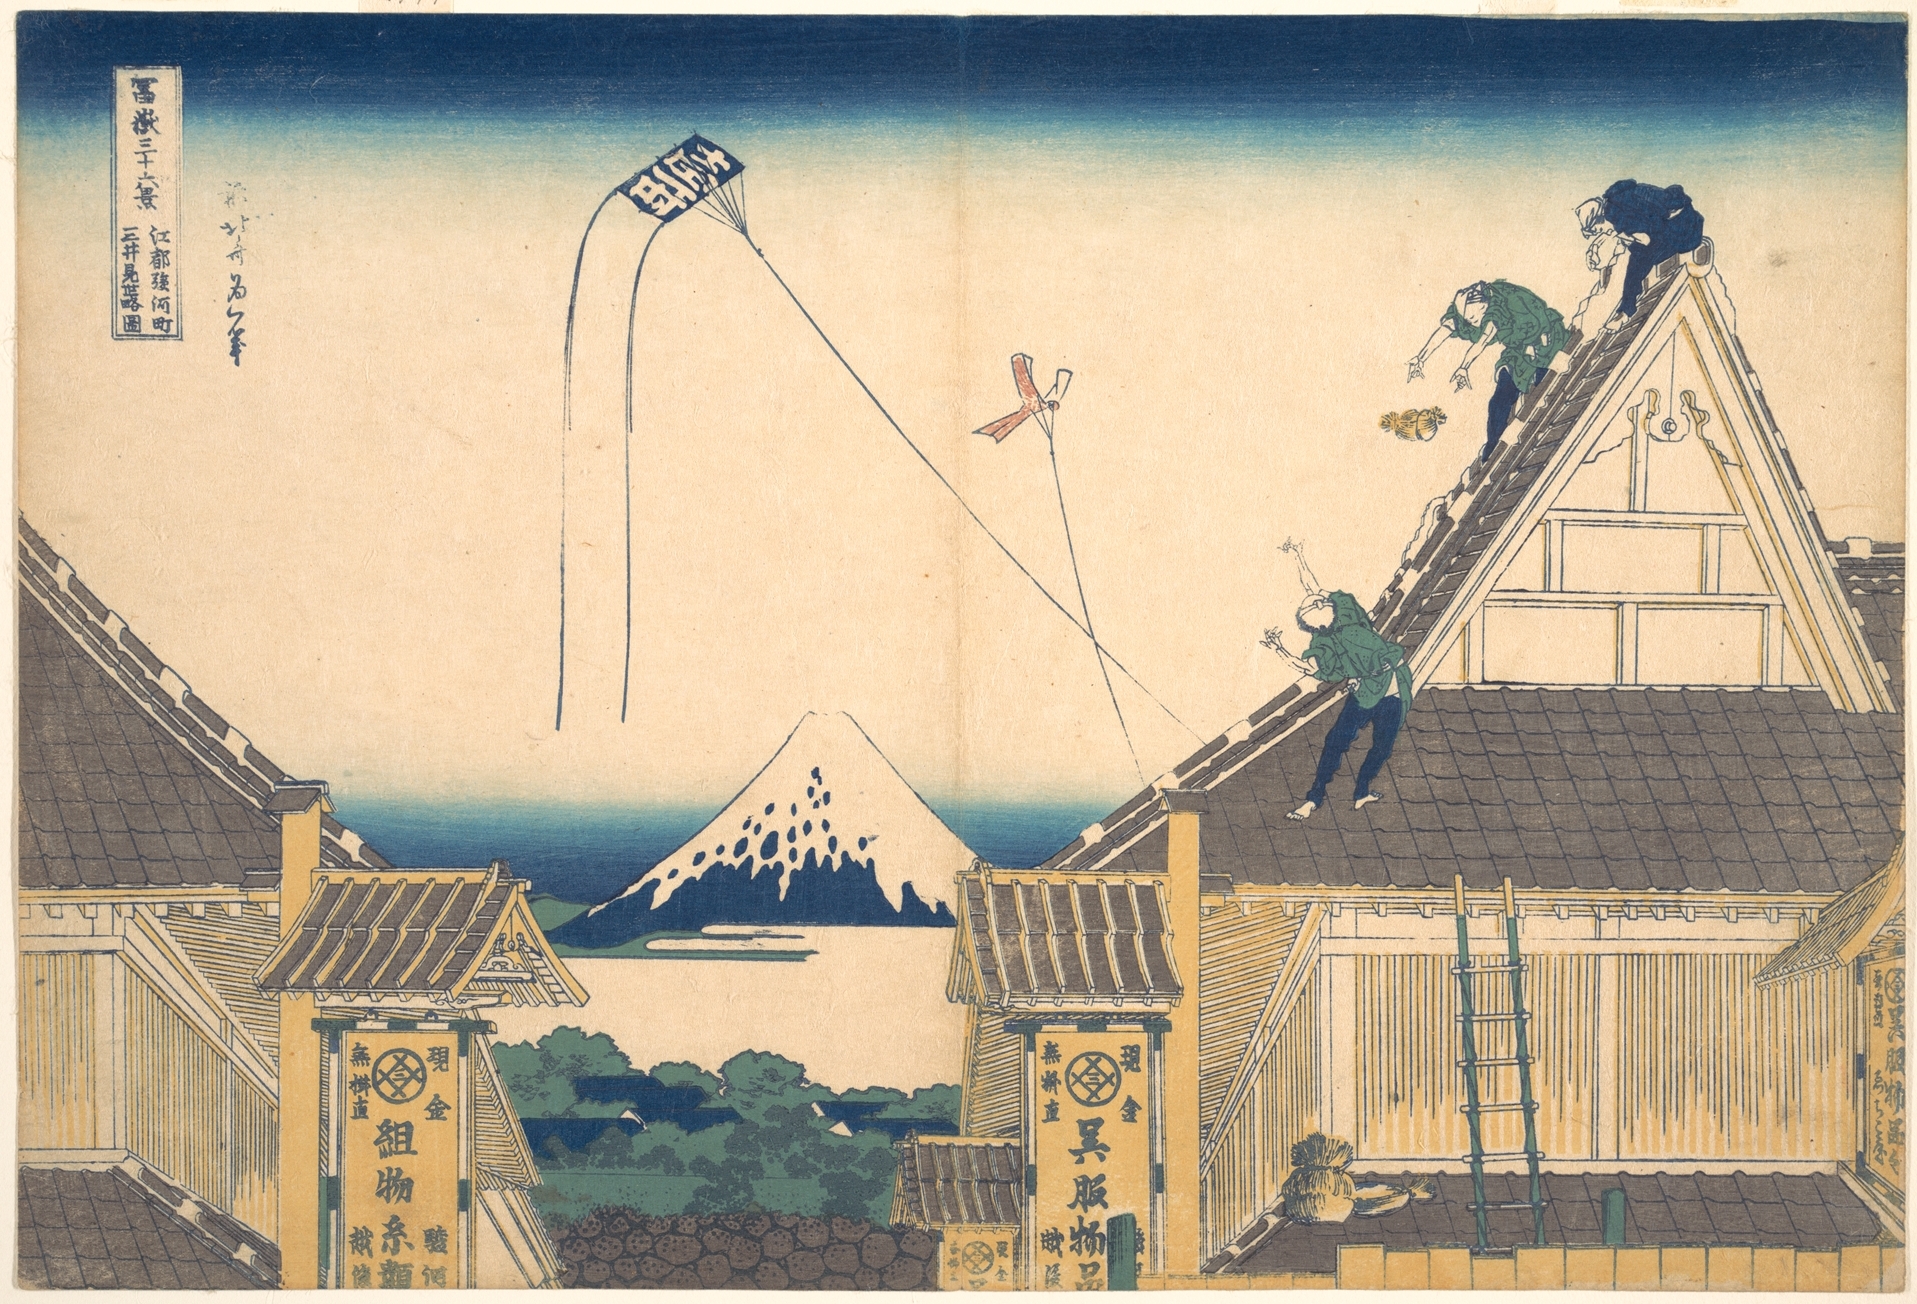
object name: woodblock print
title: Mitsui Shop at Surugachō in Edo (Edo Surugachō Mitsui mise ryaku zu), from the series Thirty-six Views of Mount Fuji (Fugaku sanjūrokkei)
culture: japanese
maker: katsushika hokusai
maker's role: artist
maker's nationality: japanese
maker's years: 1760-1849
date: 1830-1832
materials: ink, paper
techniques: woodblock print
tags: houses,men,mountains